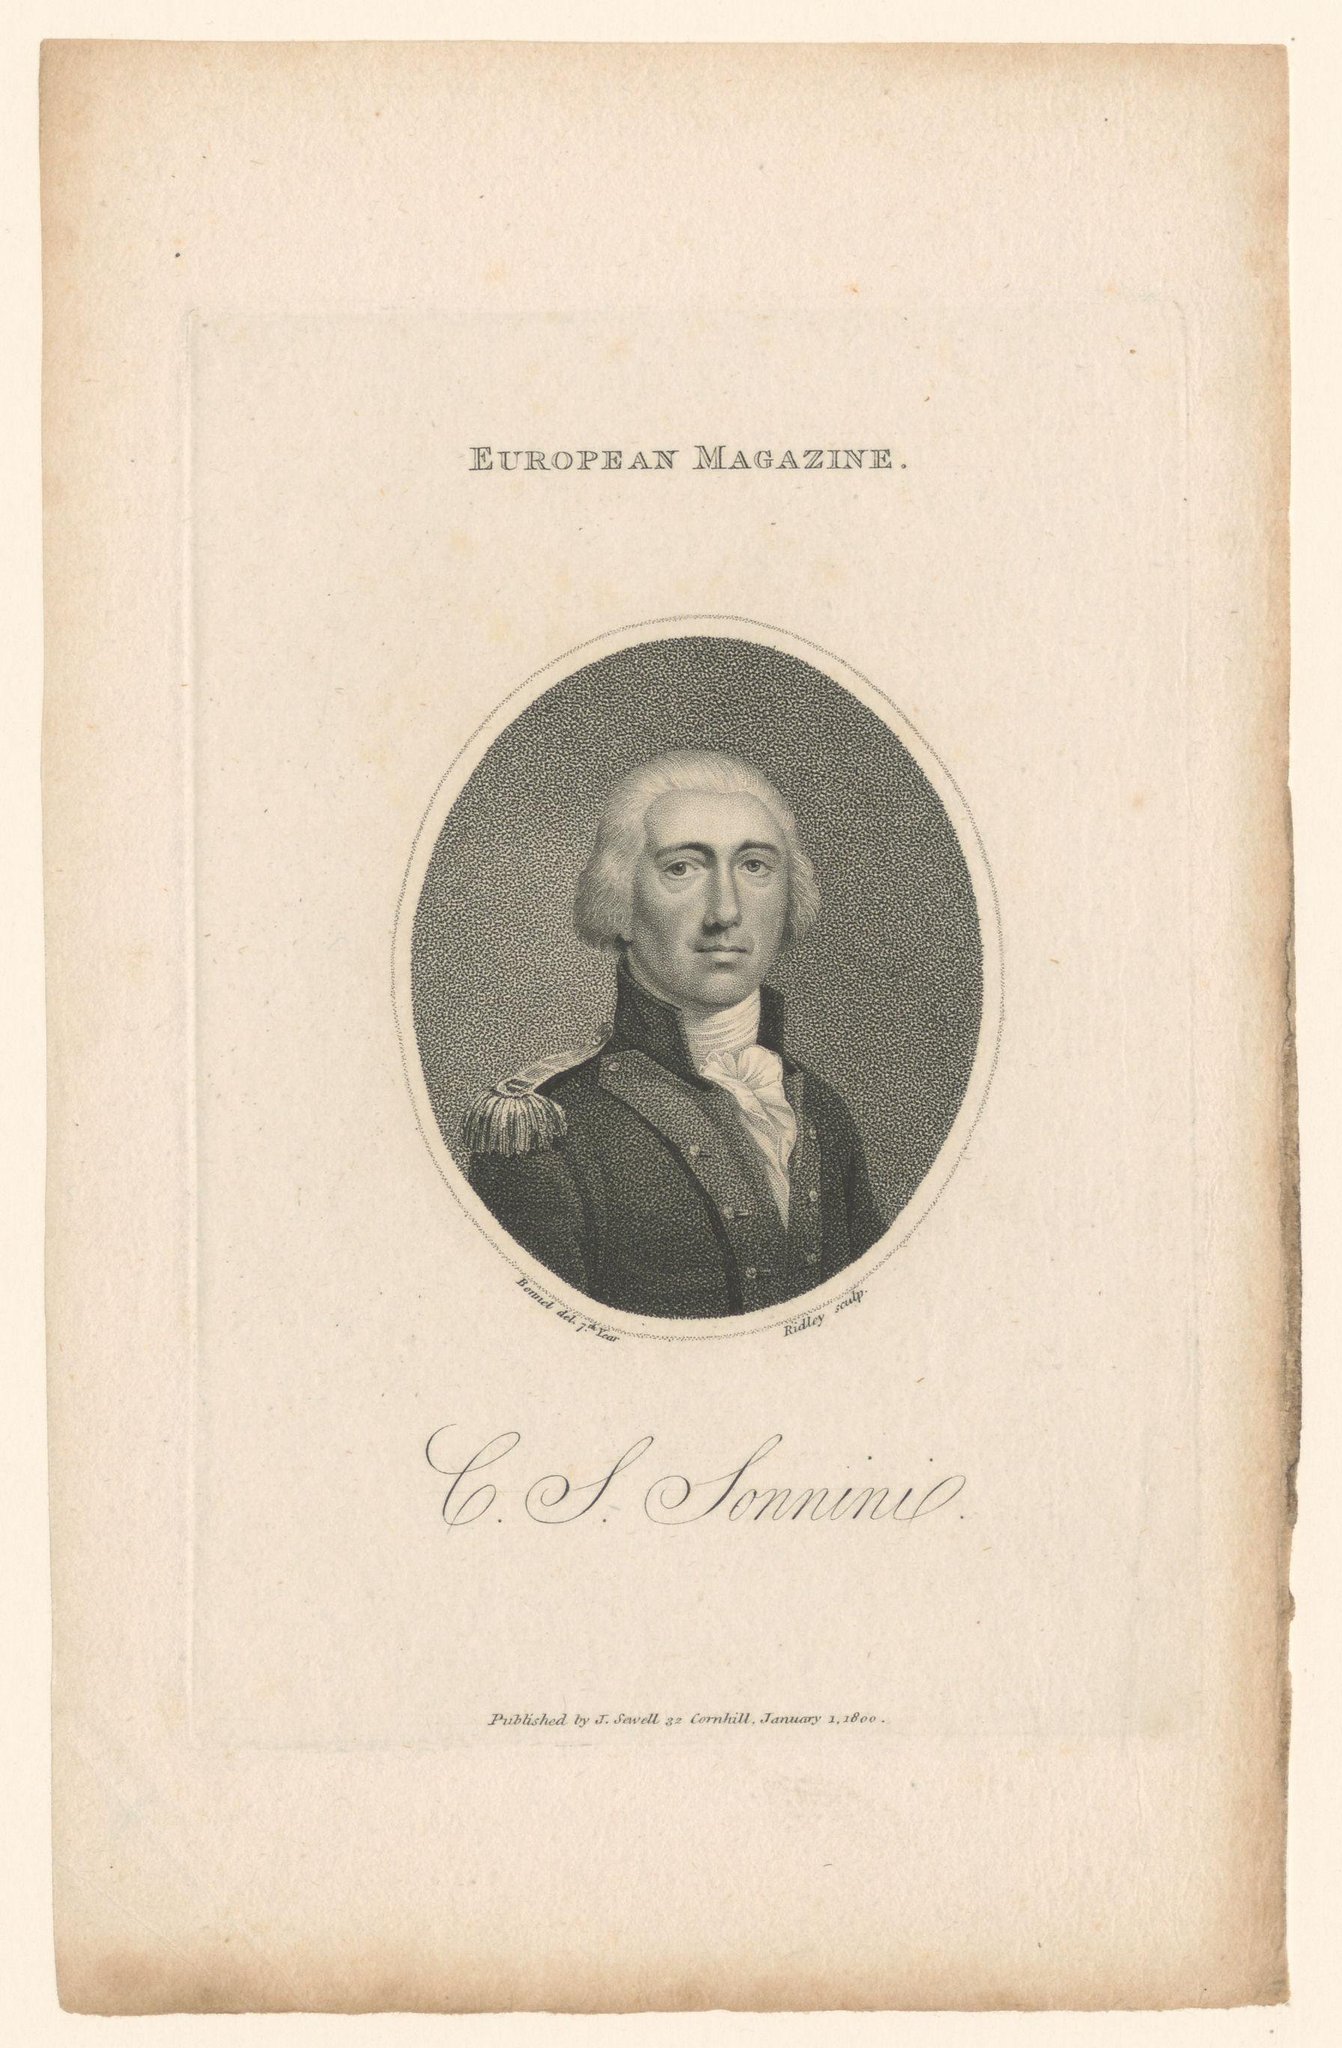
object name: print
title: Portret van Charles-Nicolas-Sigisbert Sonnini de Manoncourt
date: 1800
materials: paper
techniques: stippling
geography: london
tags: paris, historical persons, exploration, expedition, voyage of discovery (+ scholar, scientist in non-work situations)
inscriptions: collector's mark: Lugt 2228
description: Prent gebruikt in: European Magazine (1800).